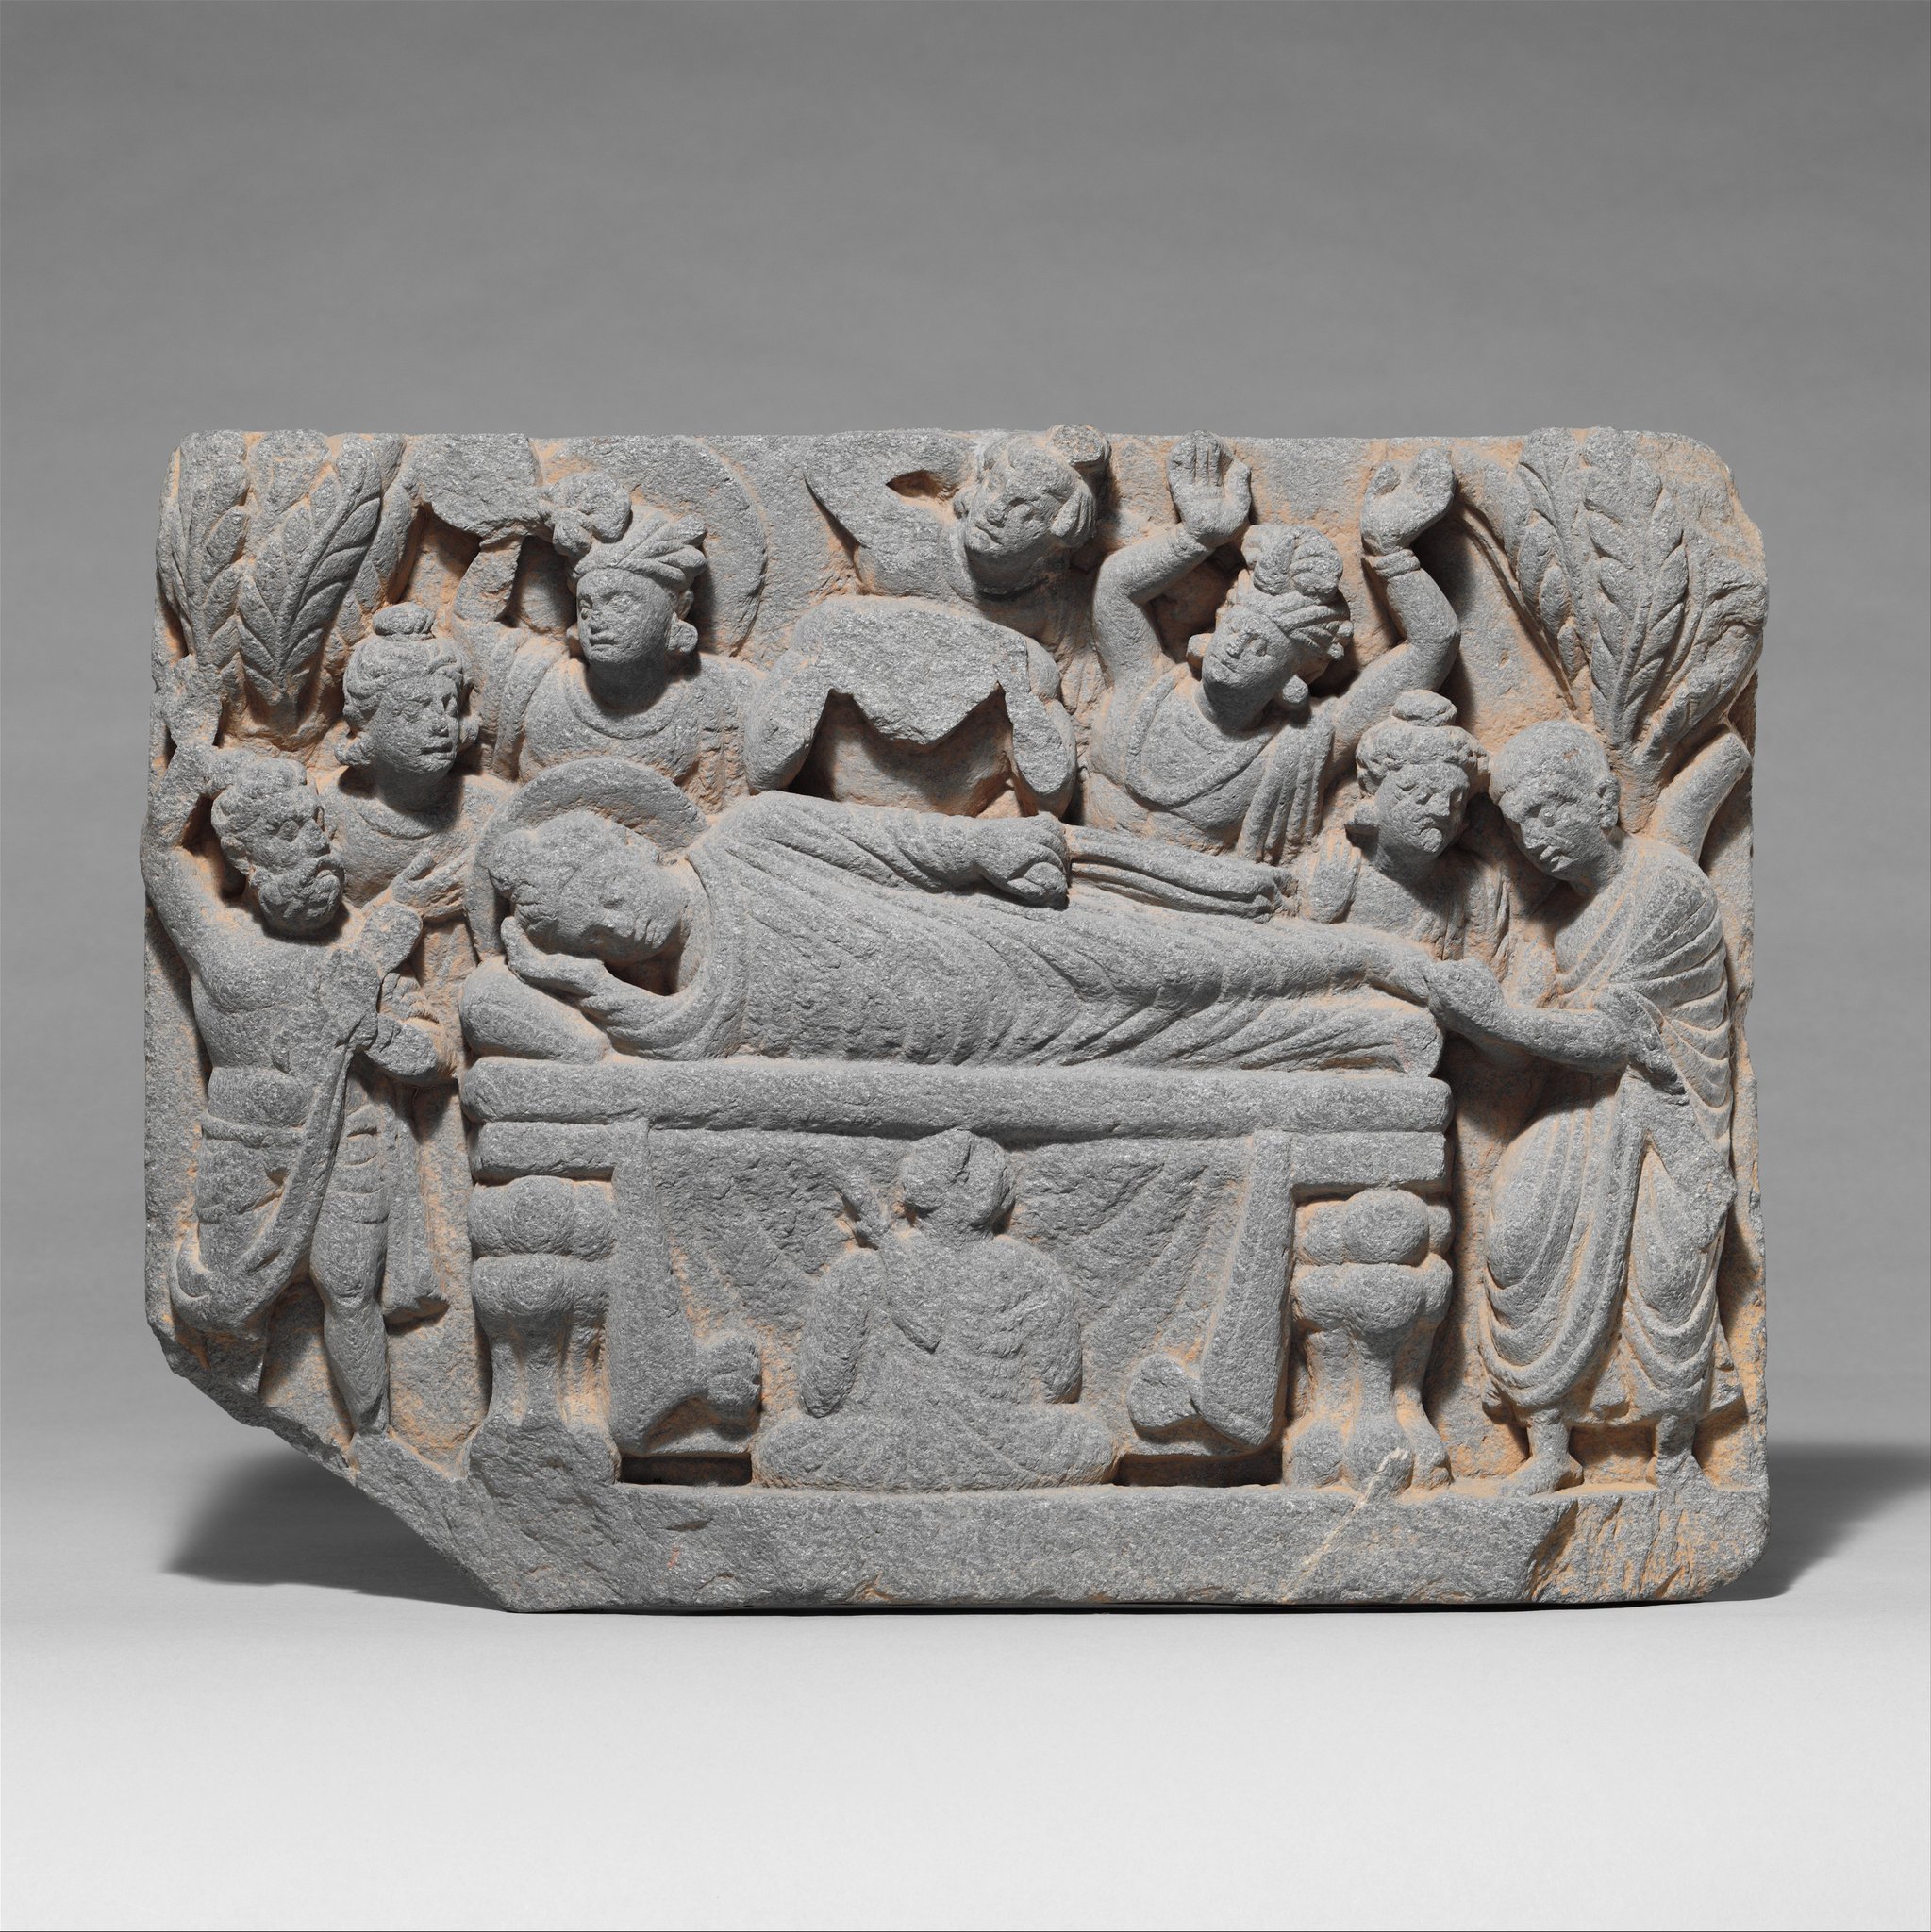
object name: relief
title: Death of the Buddha (Parinirvana)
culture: gandhara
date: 101-300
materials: stone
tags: gandhara,sadness,men,buddhism,buddha,death